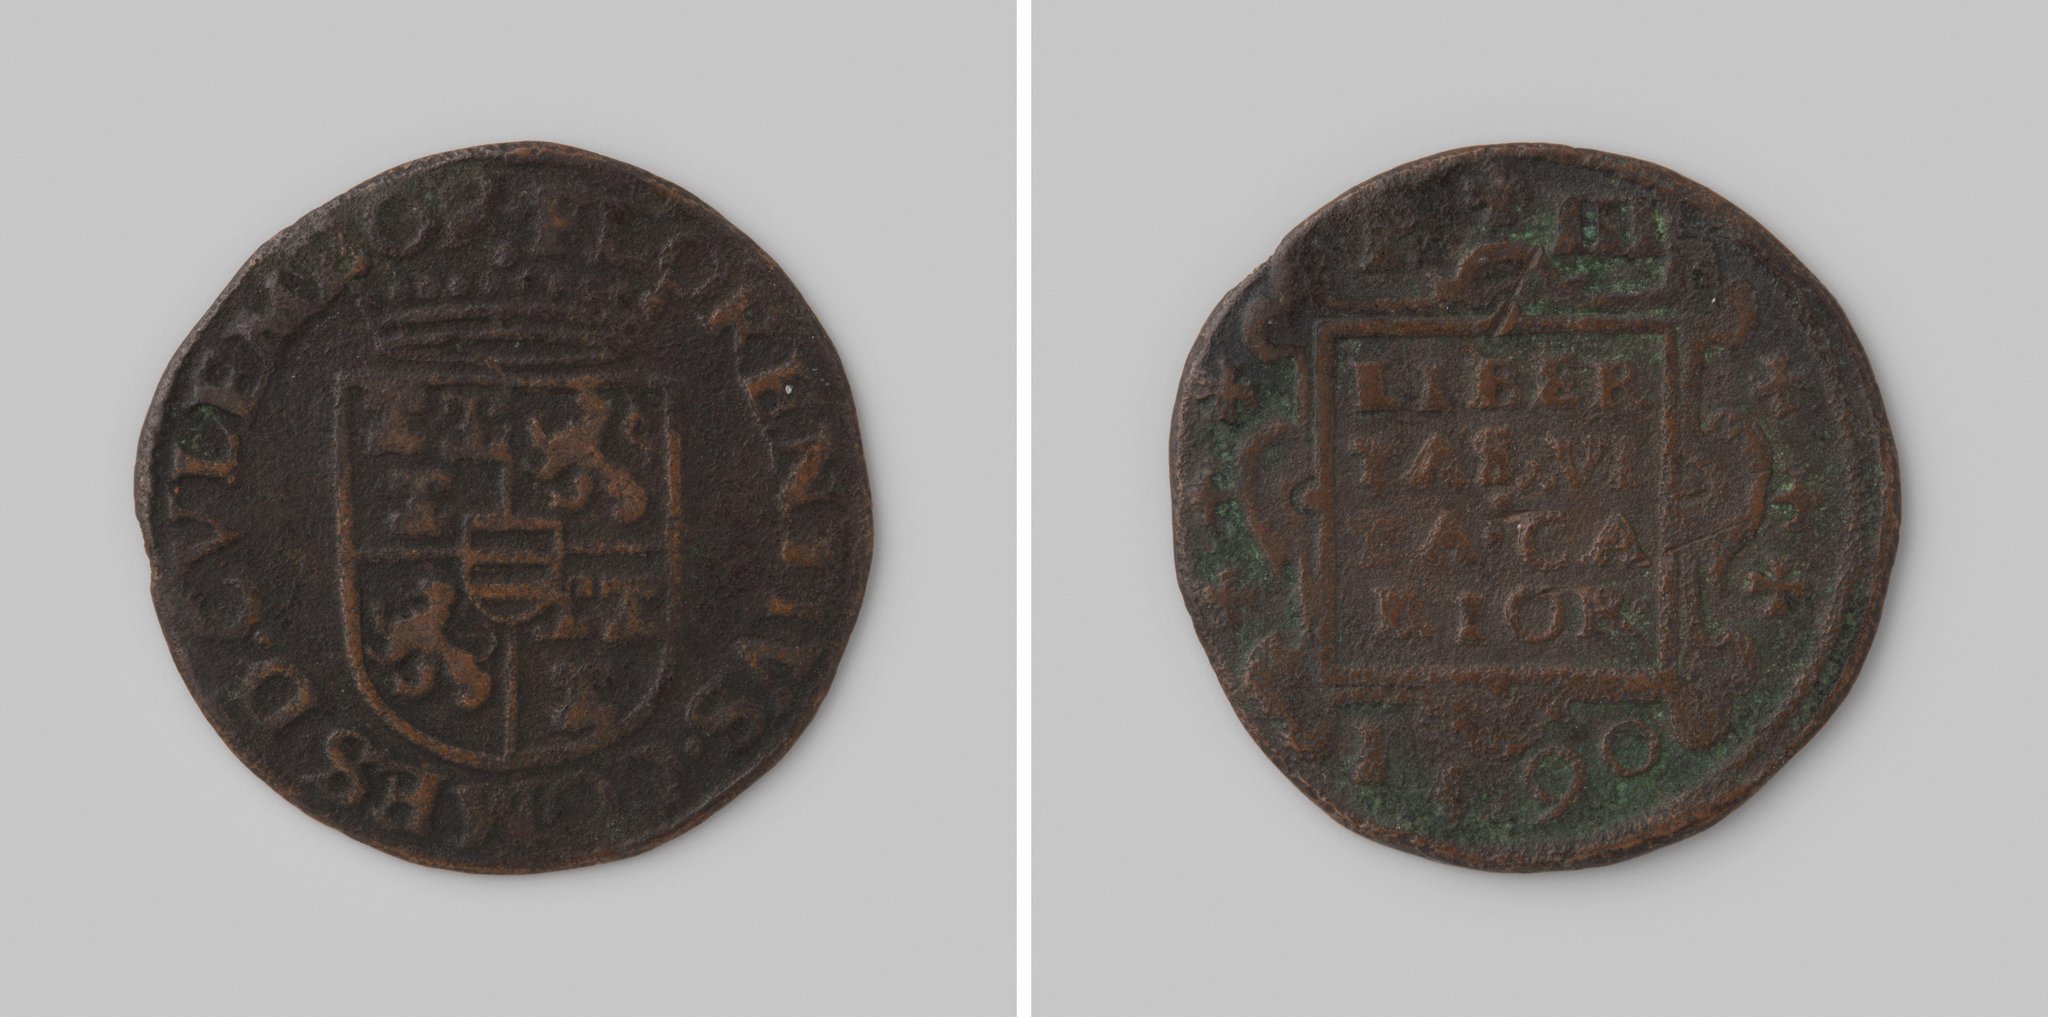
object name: coin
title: Culemborgse oord, 1590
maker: floris i van pallandt (graaf van culemborg)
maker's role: earl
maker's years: 1537-1598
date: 1590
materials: copper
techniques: striking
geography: culemborg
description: Koperen munt. Voorzijde: gekroond wapenschild van de graaf van Culemborg. Keerzijde: binnen versierd vierkant opschrift in vier regels regels. Aan bovenkant van vierkant waarde-aanduiding P IIII [=4 penningen]